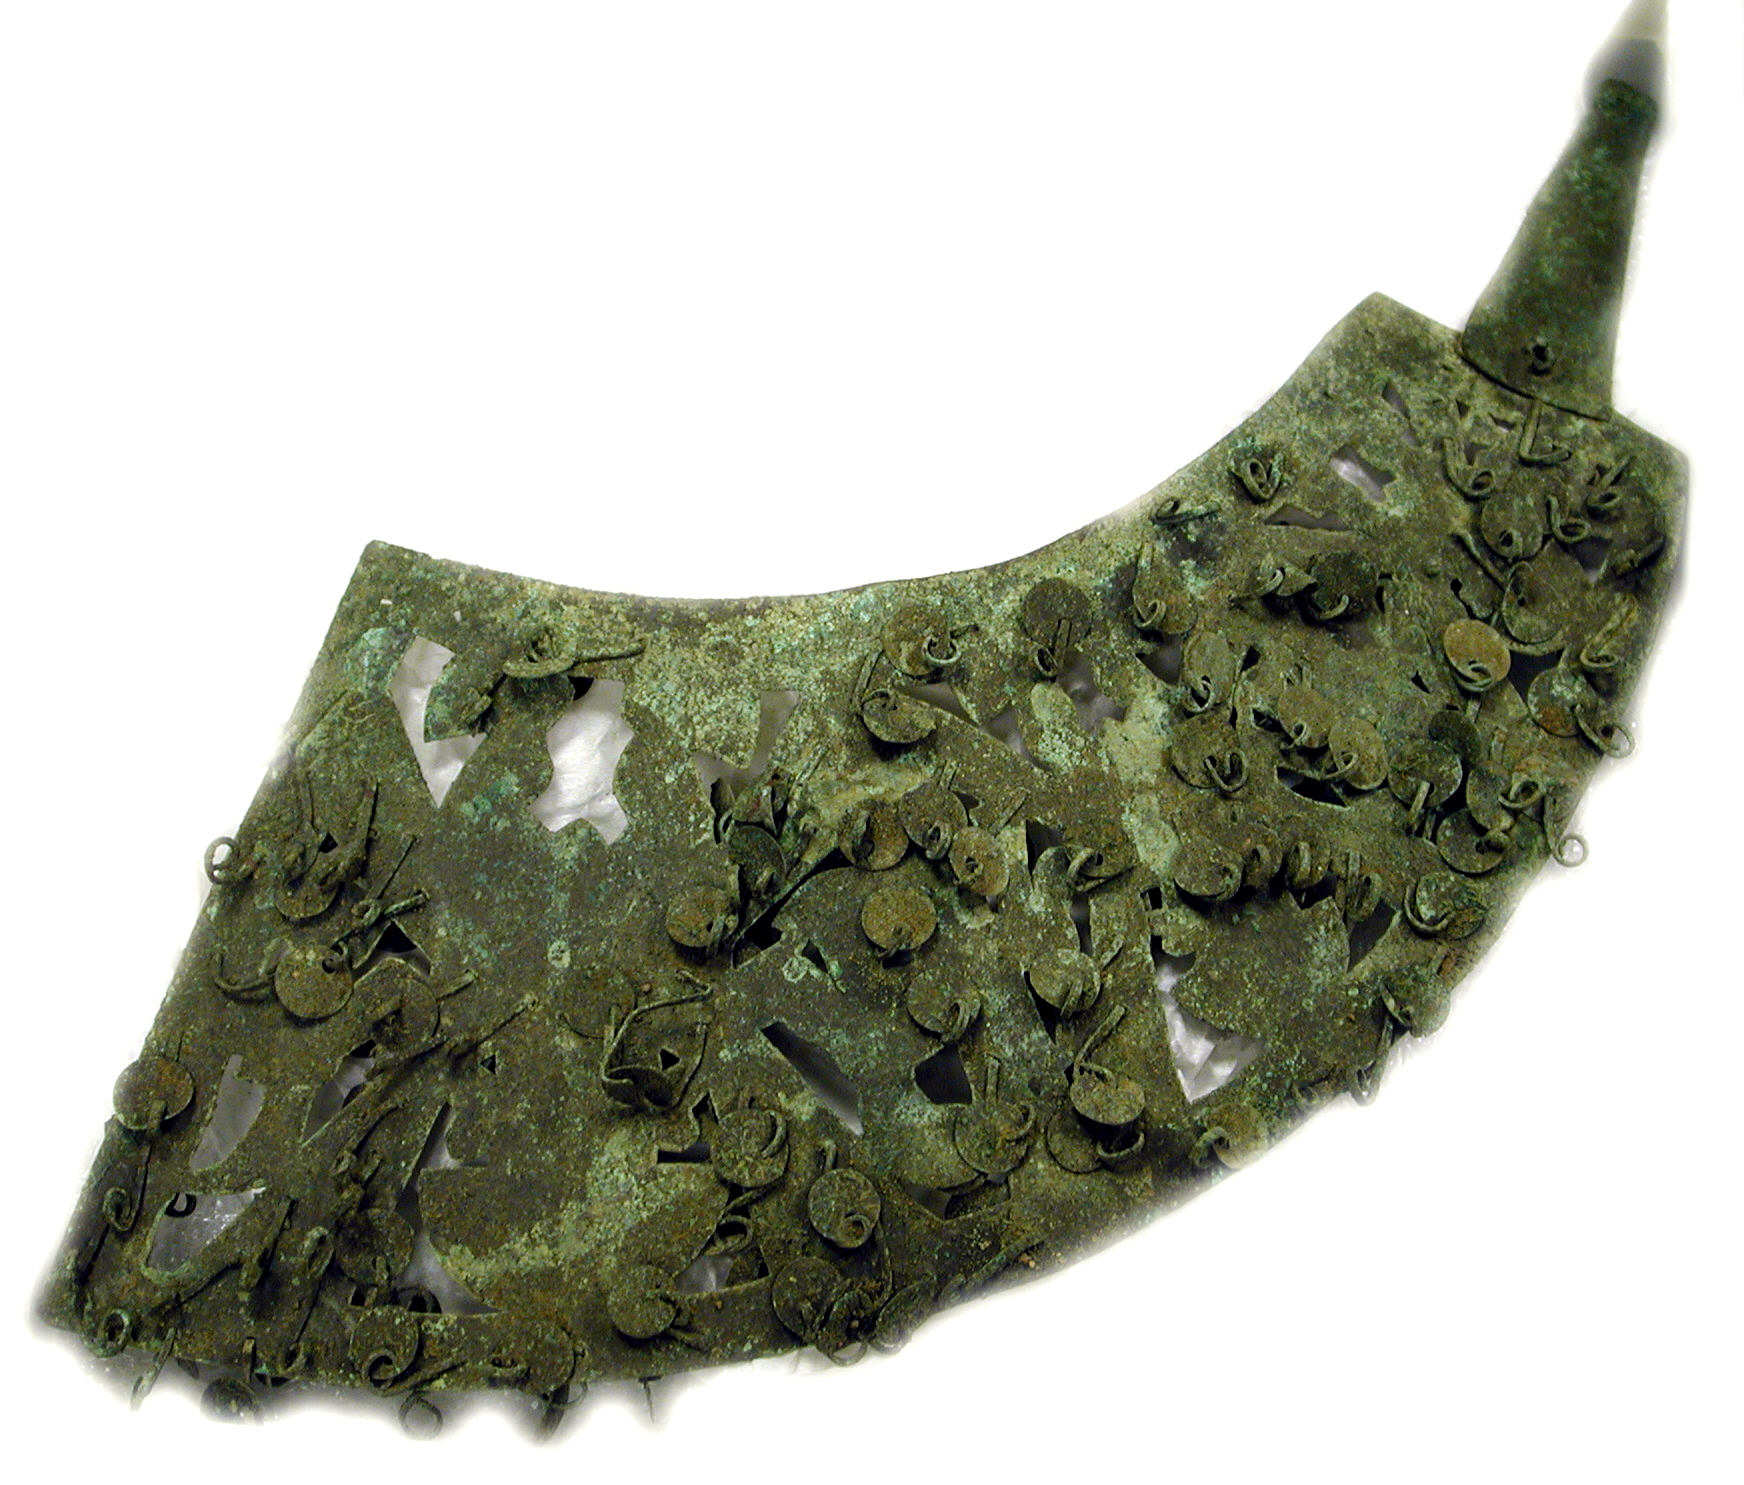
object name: ornament fragment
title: Headdress Fragment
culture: moche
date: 501-700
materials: gilt copper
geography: peru